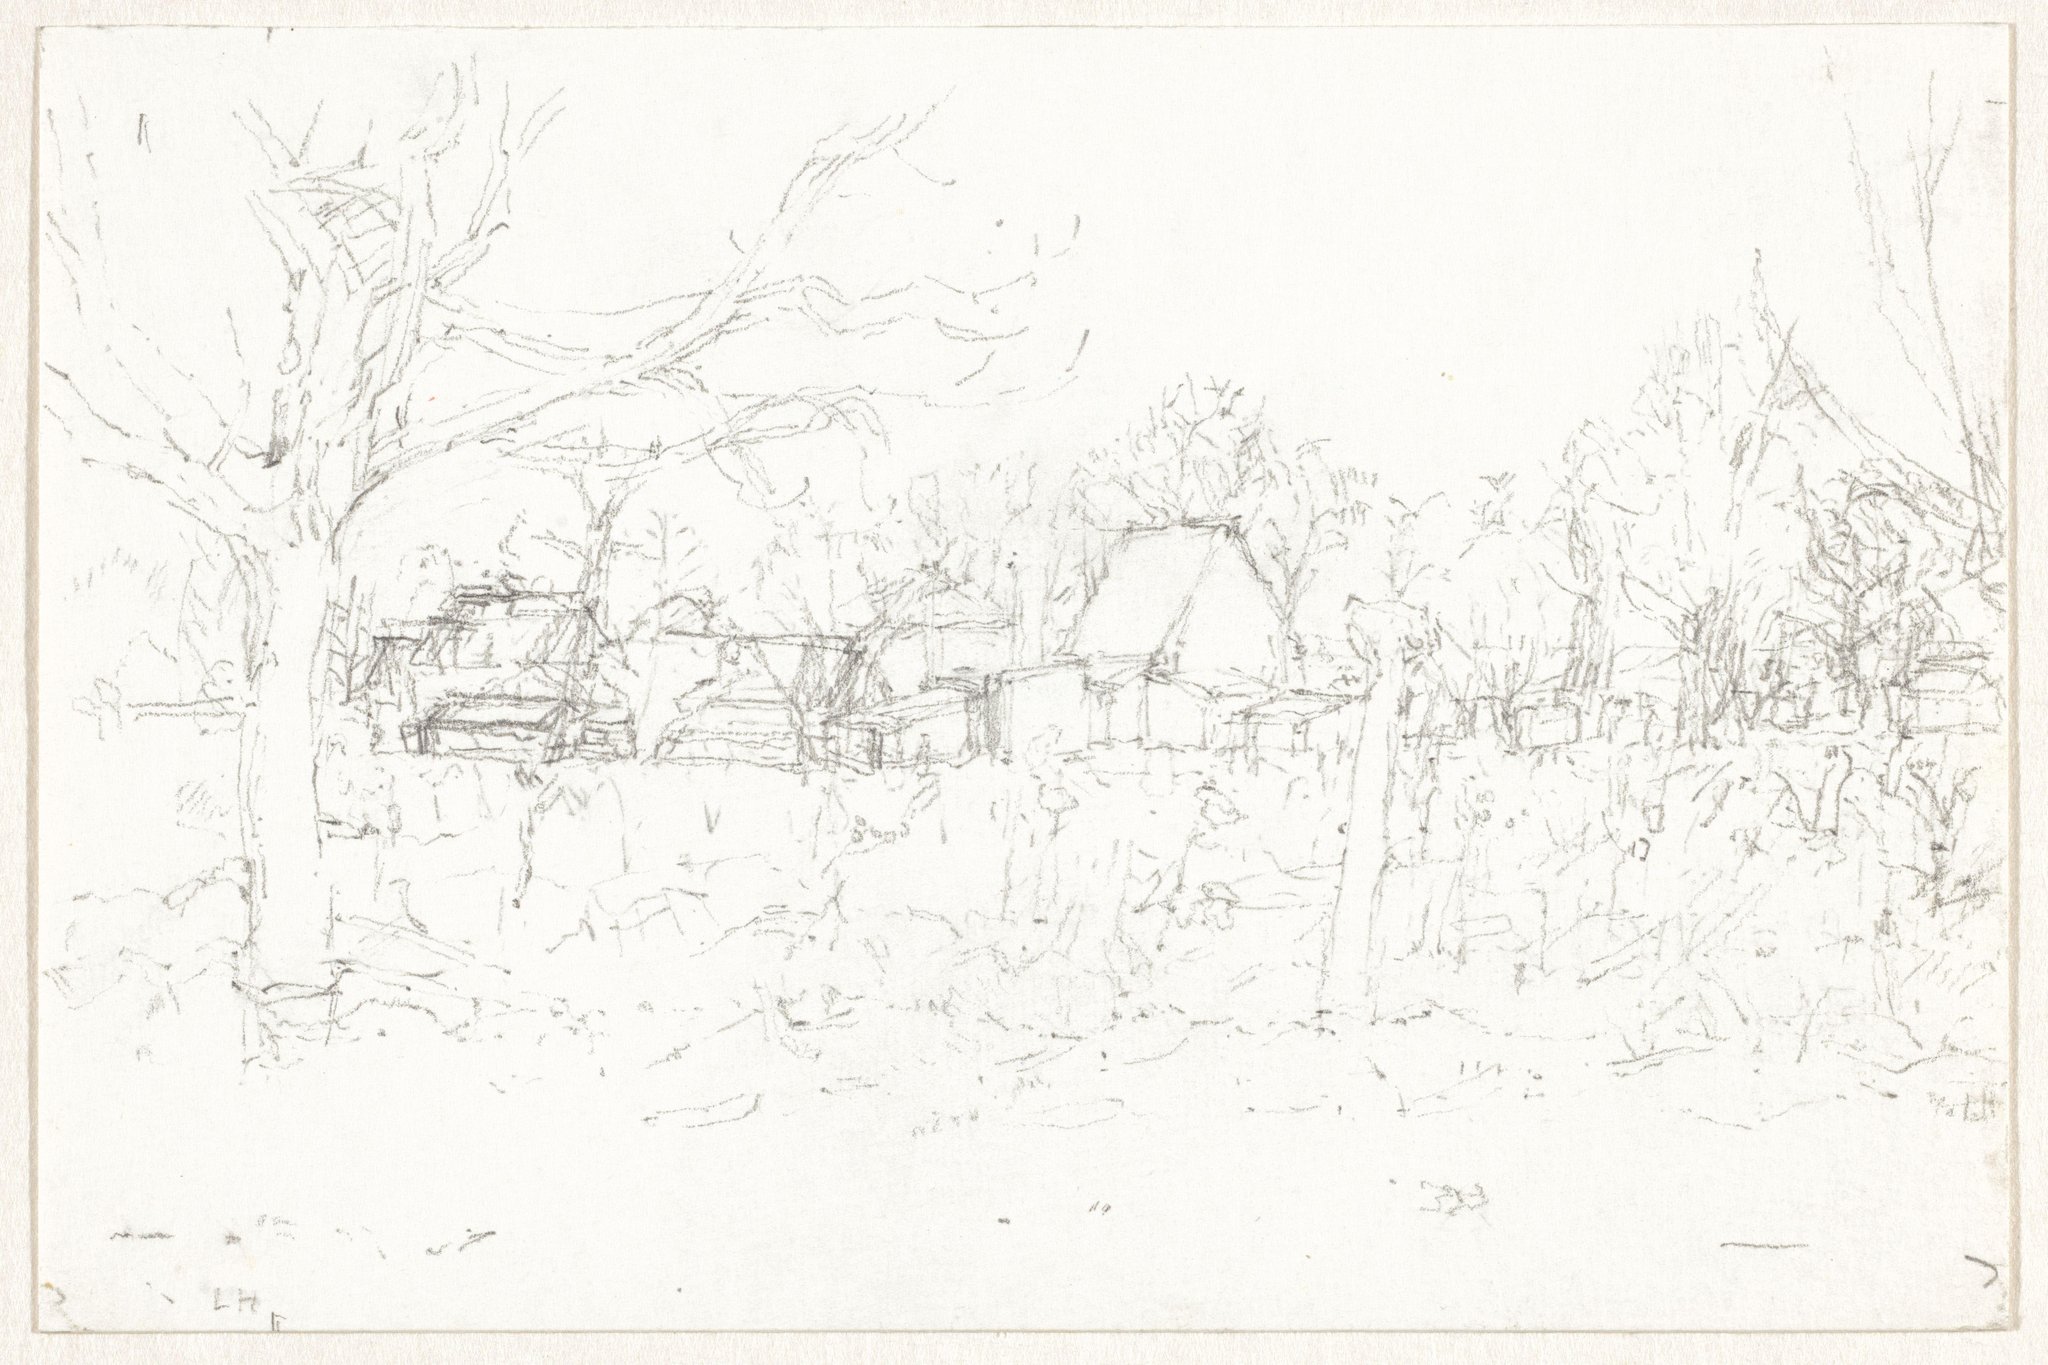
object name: drawing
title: Middelpolder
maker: lau heidendael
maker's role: print maker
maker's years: 1946-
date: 2009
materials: paper, pencil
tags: polder, reclaimed land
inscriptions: monogram: ‘LH’, title: ‘middelpolder’